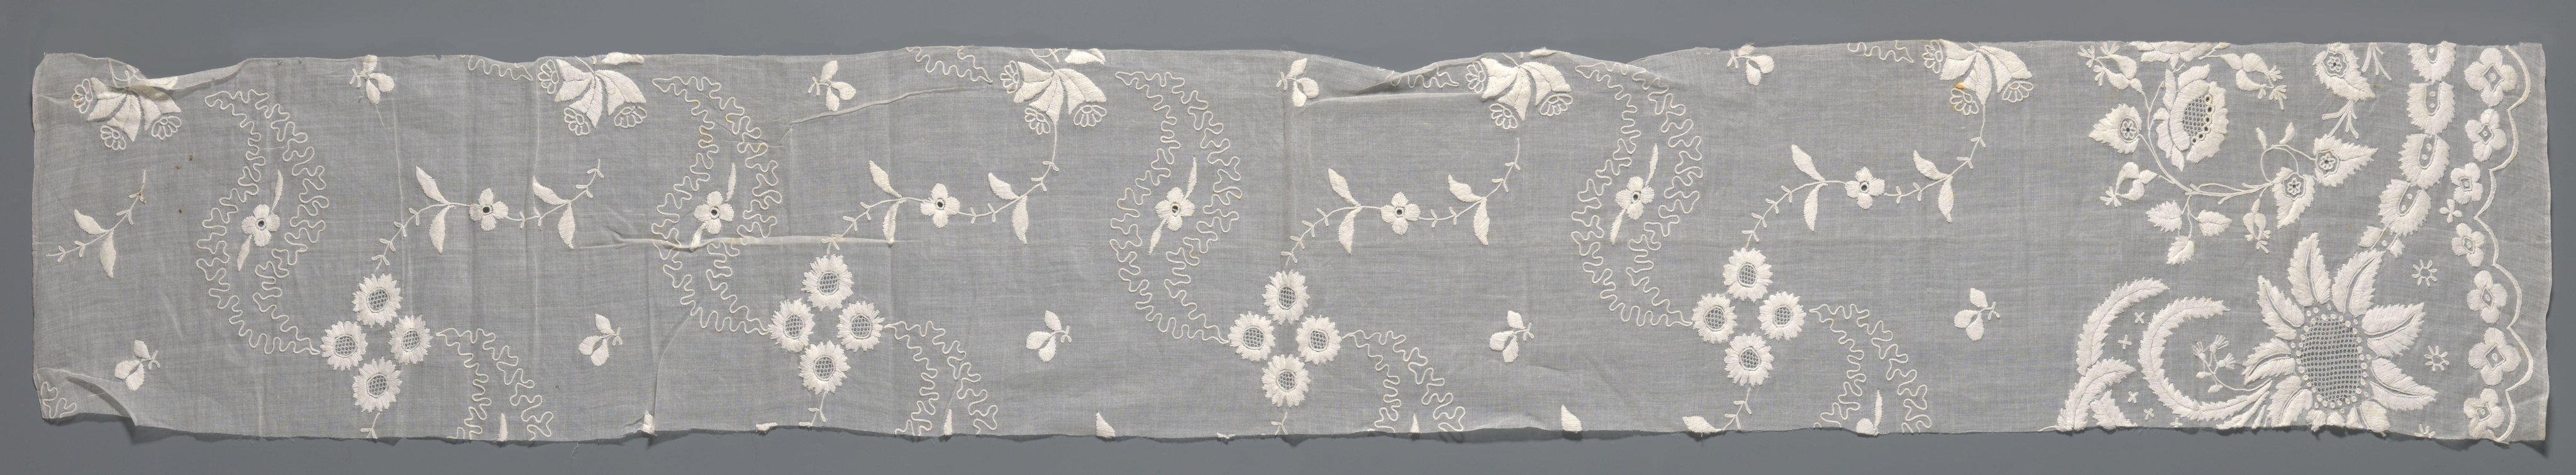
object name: curtain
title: Weefsel van een gordijn van glasbatist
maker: Anonymous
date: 1800-1874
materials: textile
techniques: stopwork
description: Weefsel van een gordijn van glasbatist, versierd met tule doorstopborduursel (wit op wit). Met briefje: 'Deze gordijnen zijn gebruikt voor de ramen van het kleedkamertje van H.M. de Koningin 16 juli 1874'.